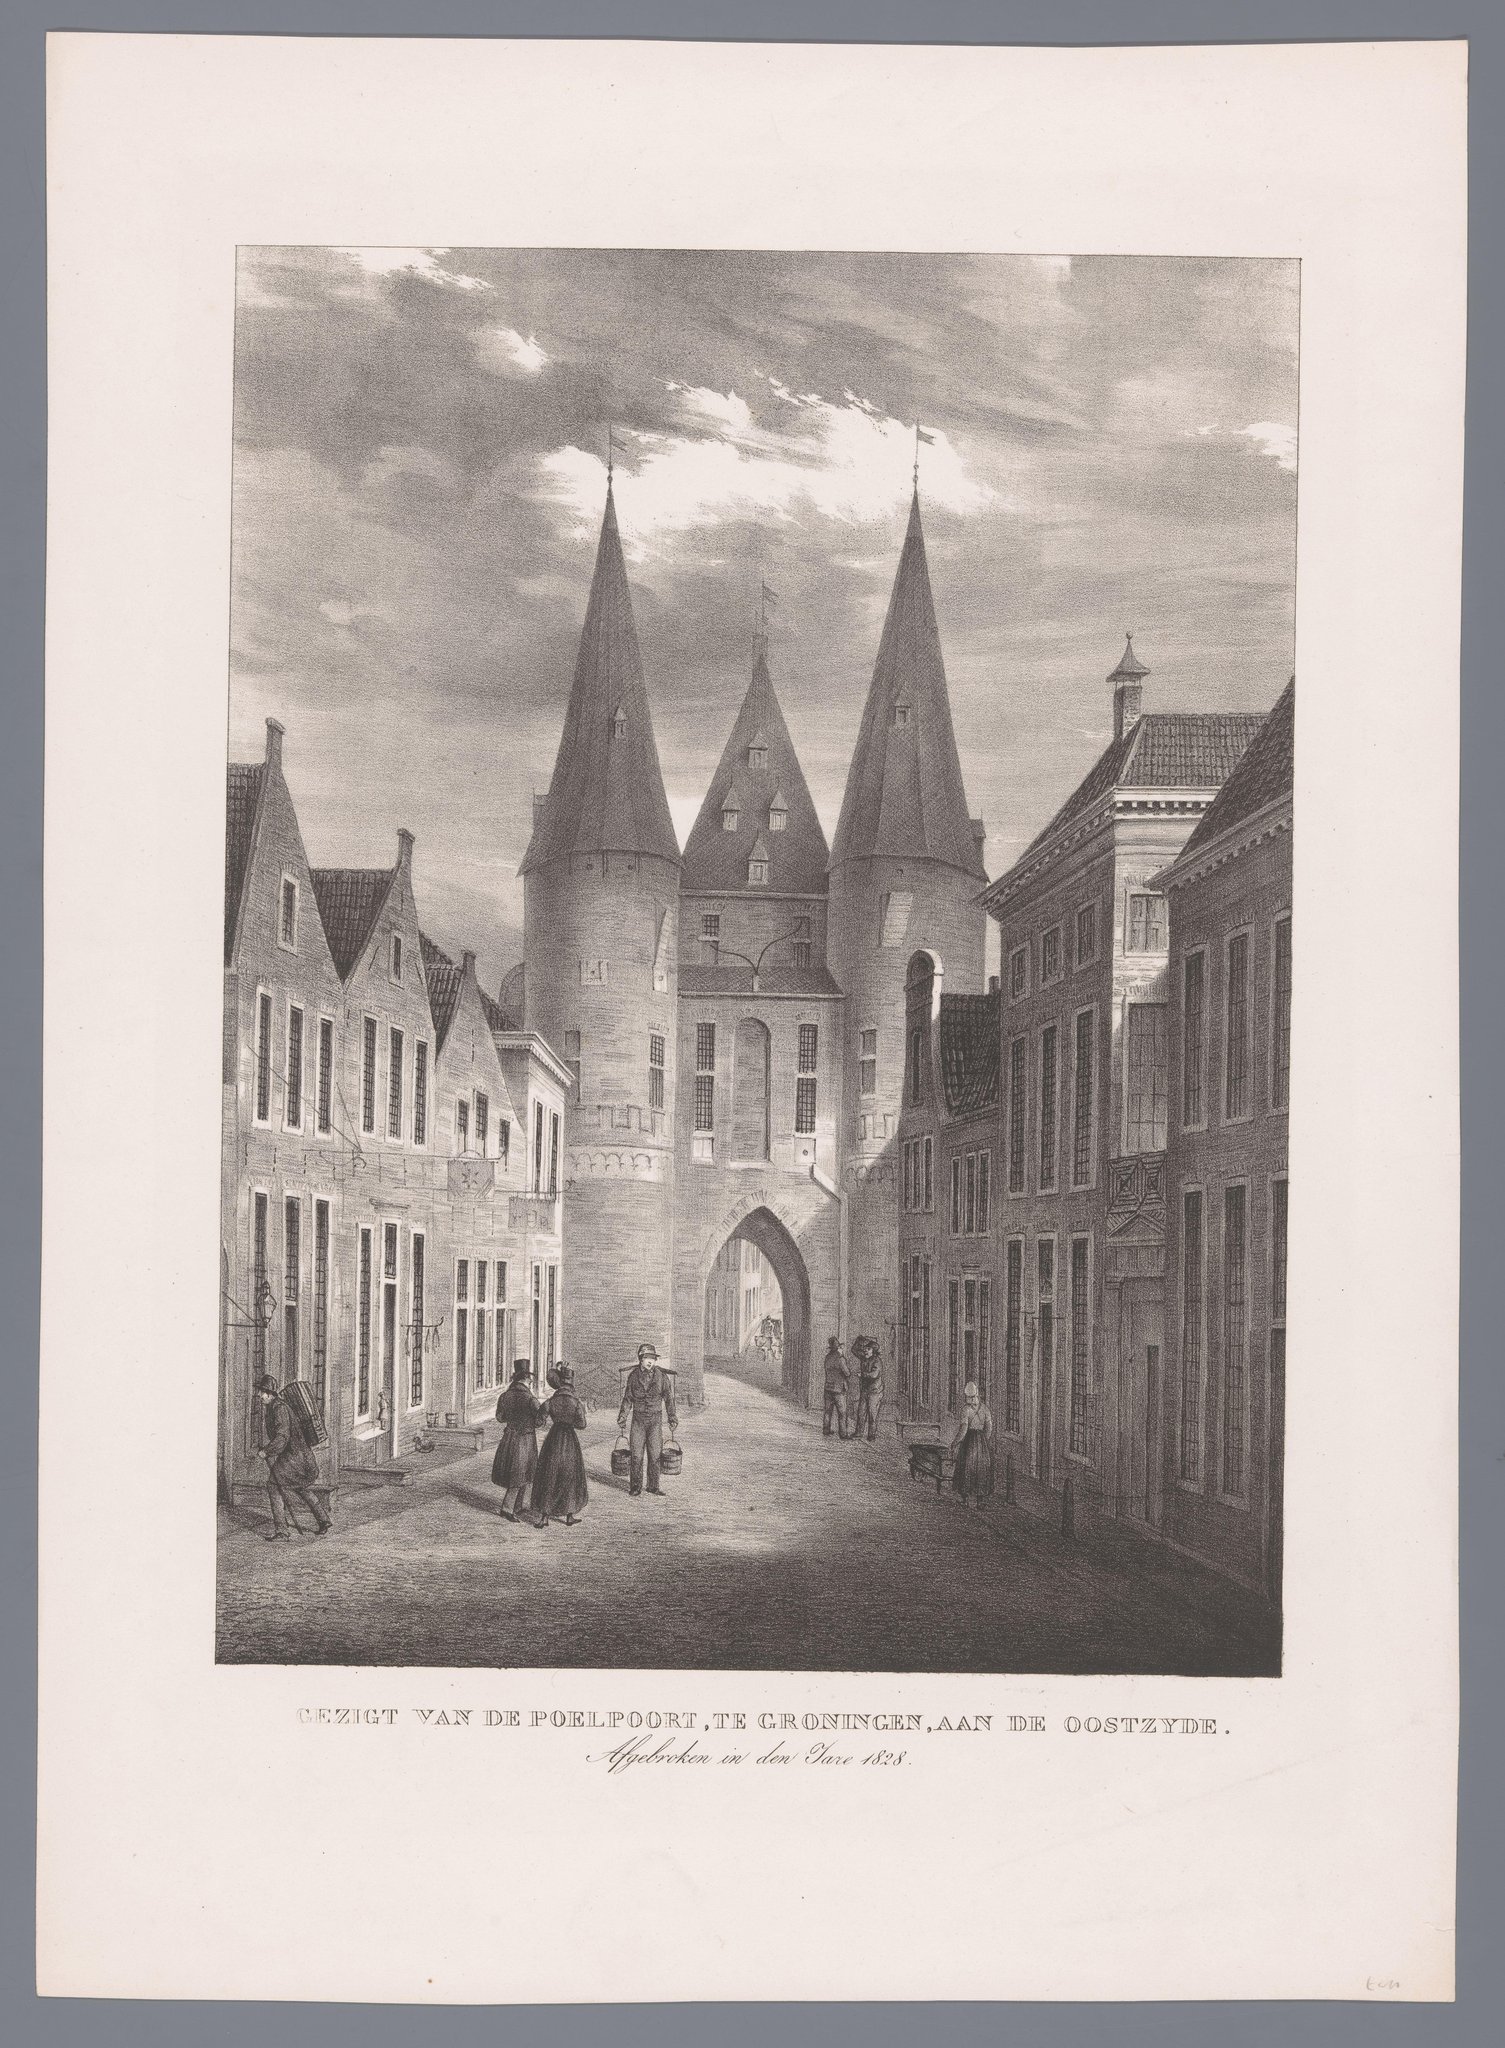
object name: print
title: Vier gezichten op de Poelpoort en de Aa poort in Groningen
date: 1832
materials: paper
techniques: lithograph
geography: groningen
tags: city-gate, city-view, and landscape with man-made constructions (+ city(-scape) with figures, staffage)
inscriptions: collector's mark: Lugt 2228